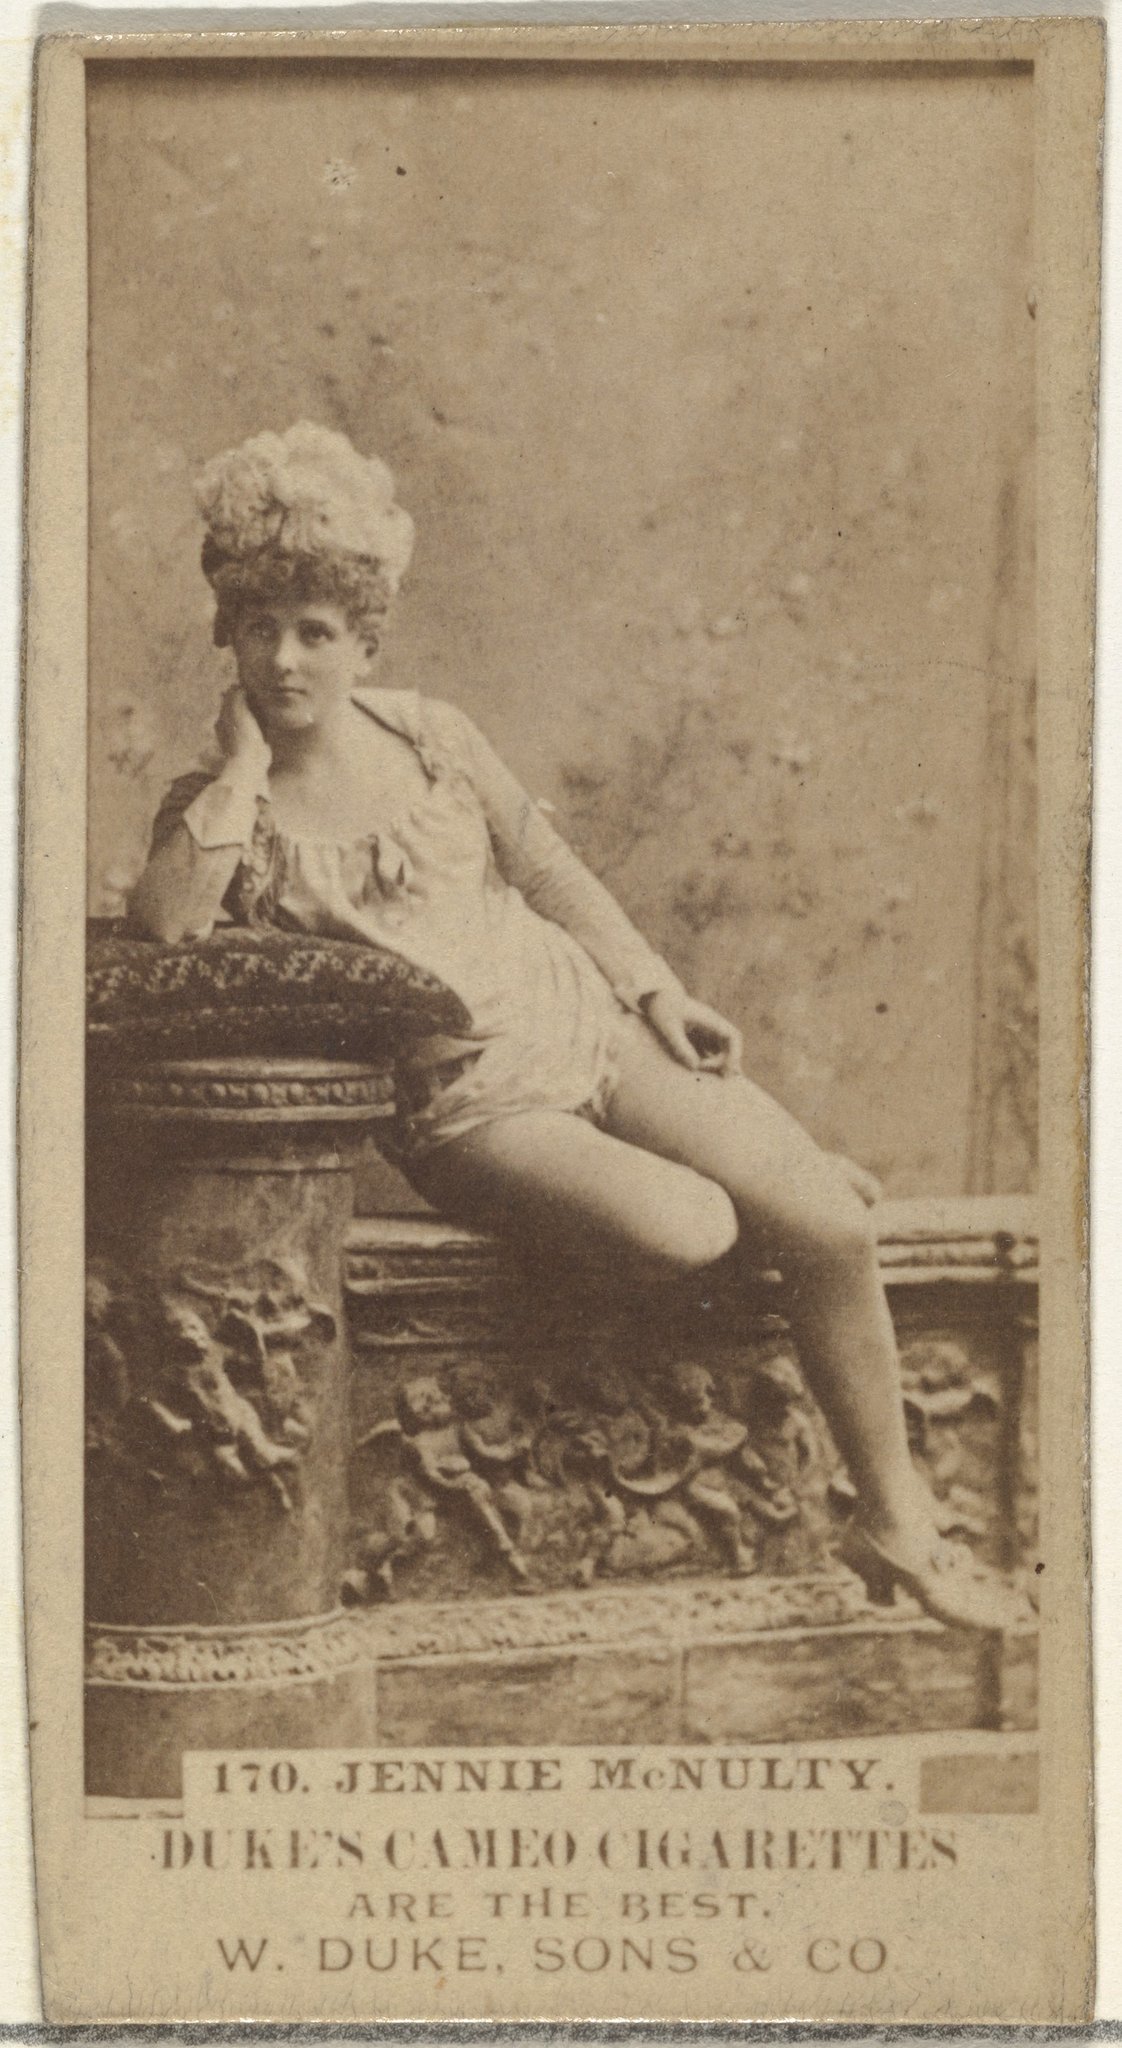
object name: photograph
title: Card Number 170, Jennie McNulty, from the Actors and Actresses series (N145-5) issued by Duke Sons & Co. to promote Cameo Cigarettes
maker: w. duke, sons & co.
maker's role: publisher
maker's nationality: american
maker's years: 1870-1920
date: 1880-1889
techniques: albumen silver print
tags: portraits,women,actresses